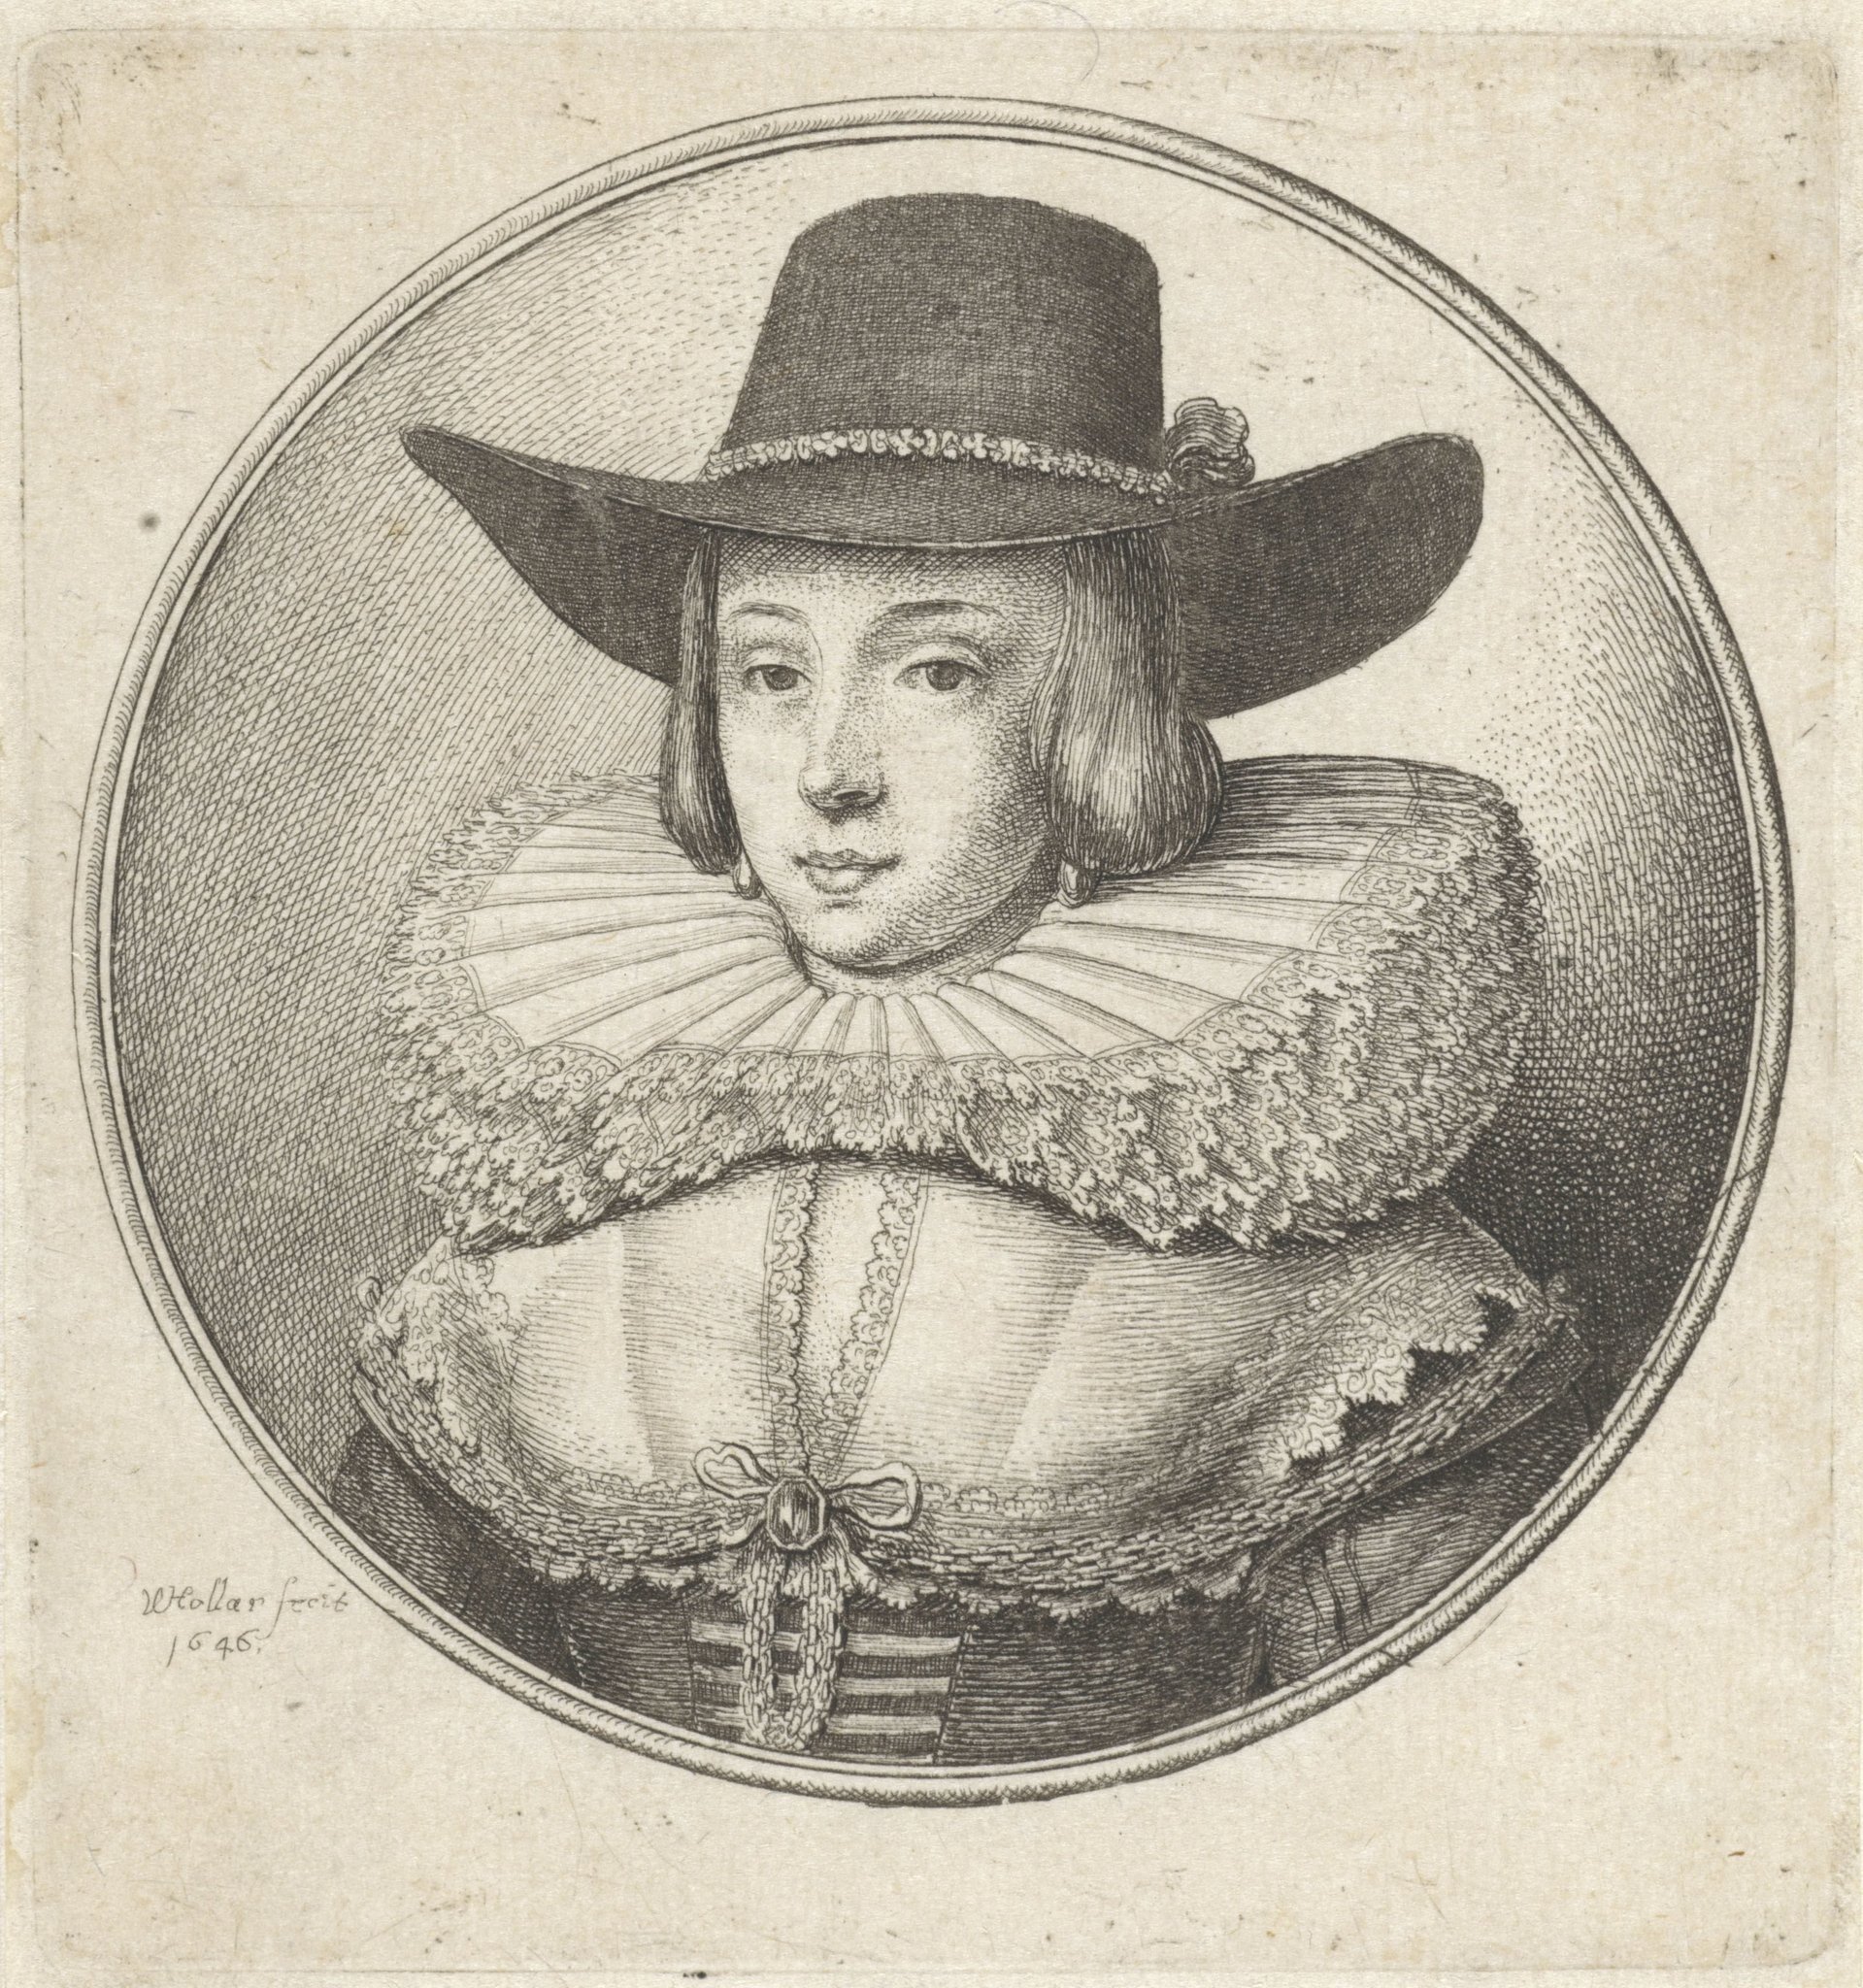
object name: print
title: Vrouwenbusten in ronde lijsten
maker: wenceslaus hollar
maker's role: draughtsman, print maker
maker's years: 1607-1677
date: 1646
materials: paper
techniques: etching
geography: antwerp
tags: head-gear: hat (+ men's clothes), anonymous historical person portrayed alone - bb - woman, neck-gear ~ clothing (with name) (+ women's clothes)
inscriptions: collector's mark: Lugt 654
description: De prent maakt deel uit van een 23-delige serie met verschillende vrouwenbusten in ronde lijsten.